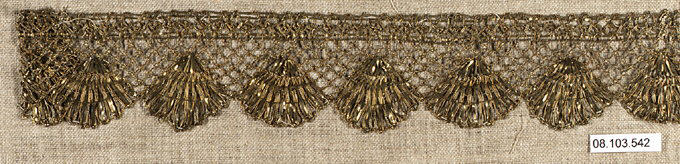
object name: piece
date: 1701-1800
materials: gold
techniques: lace